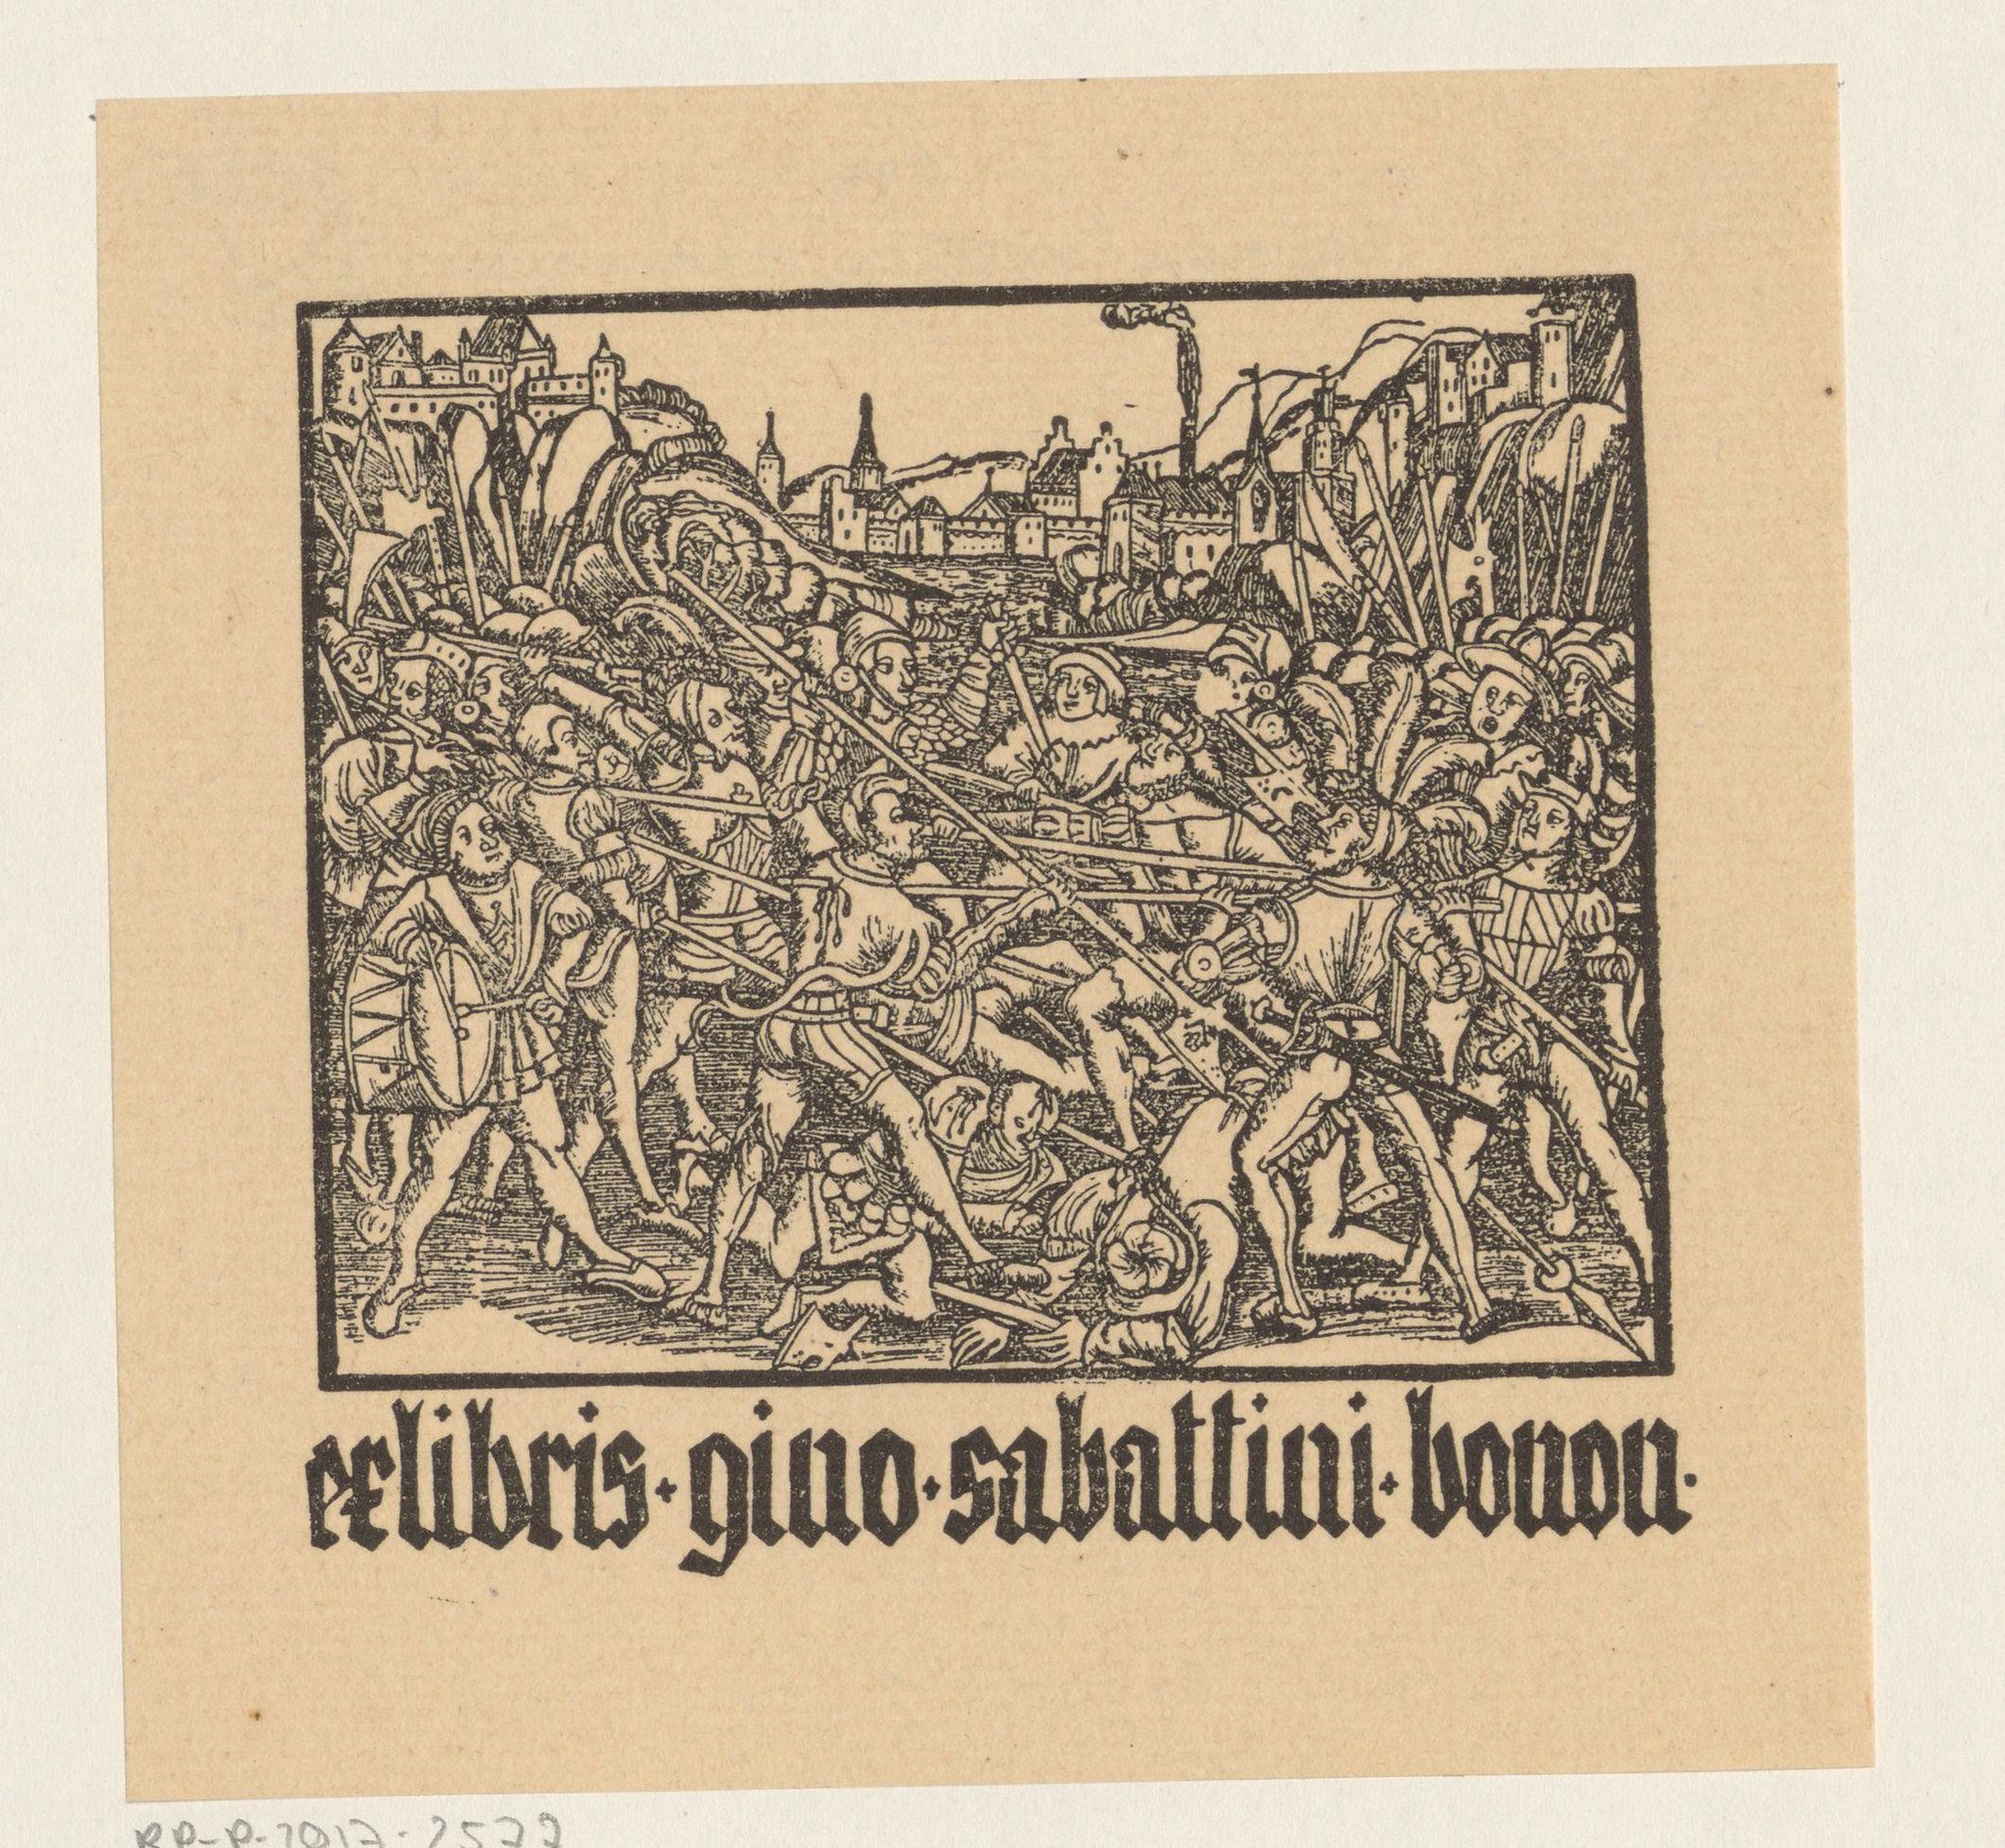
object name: bookplate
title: Ex libris van Gino Sabattini Bonon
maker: Anonymous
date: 1930-1960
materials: paper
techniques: printing block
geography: italy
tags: gino sabattini, battle, prospect of city, town panorama, silhouette of city